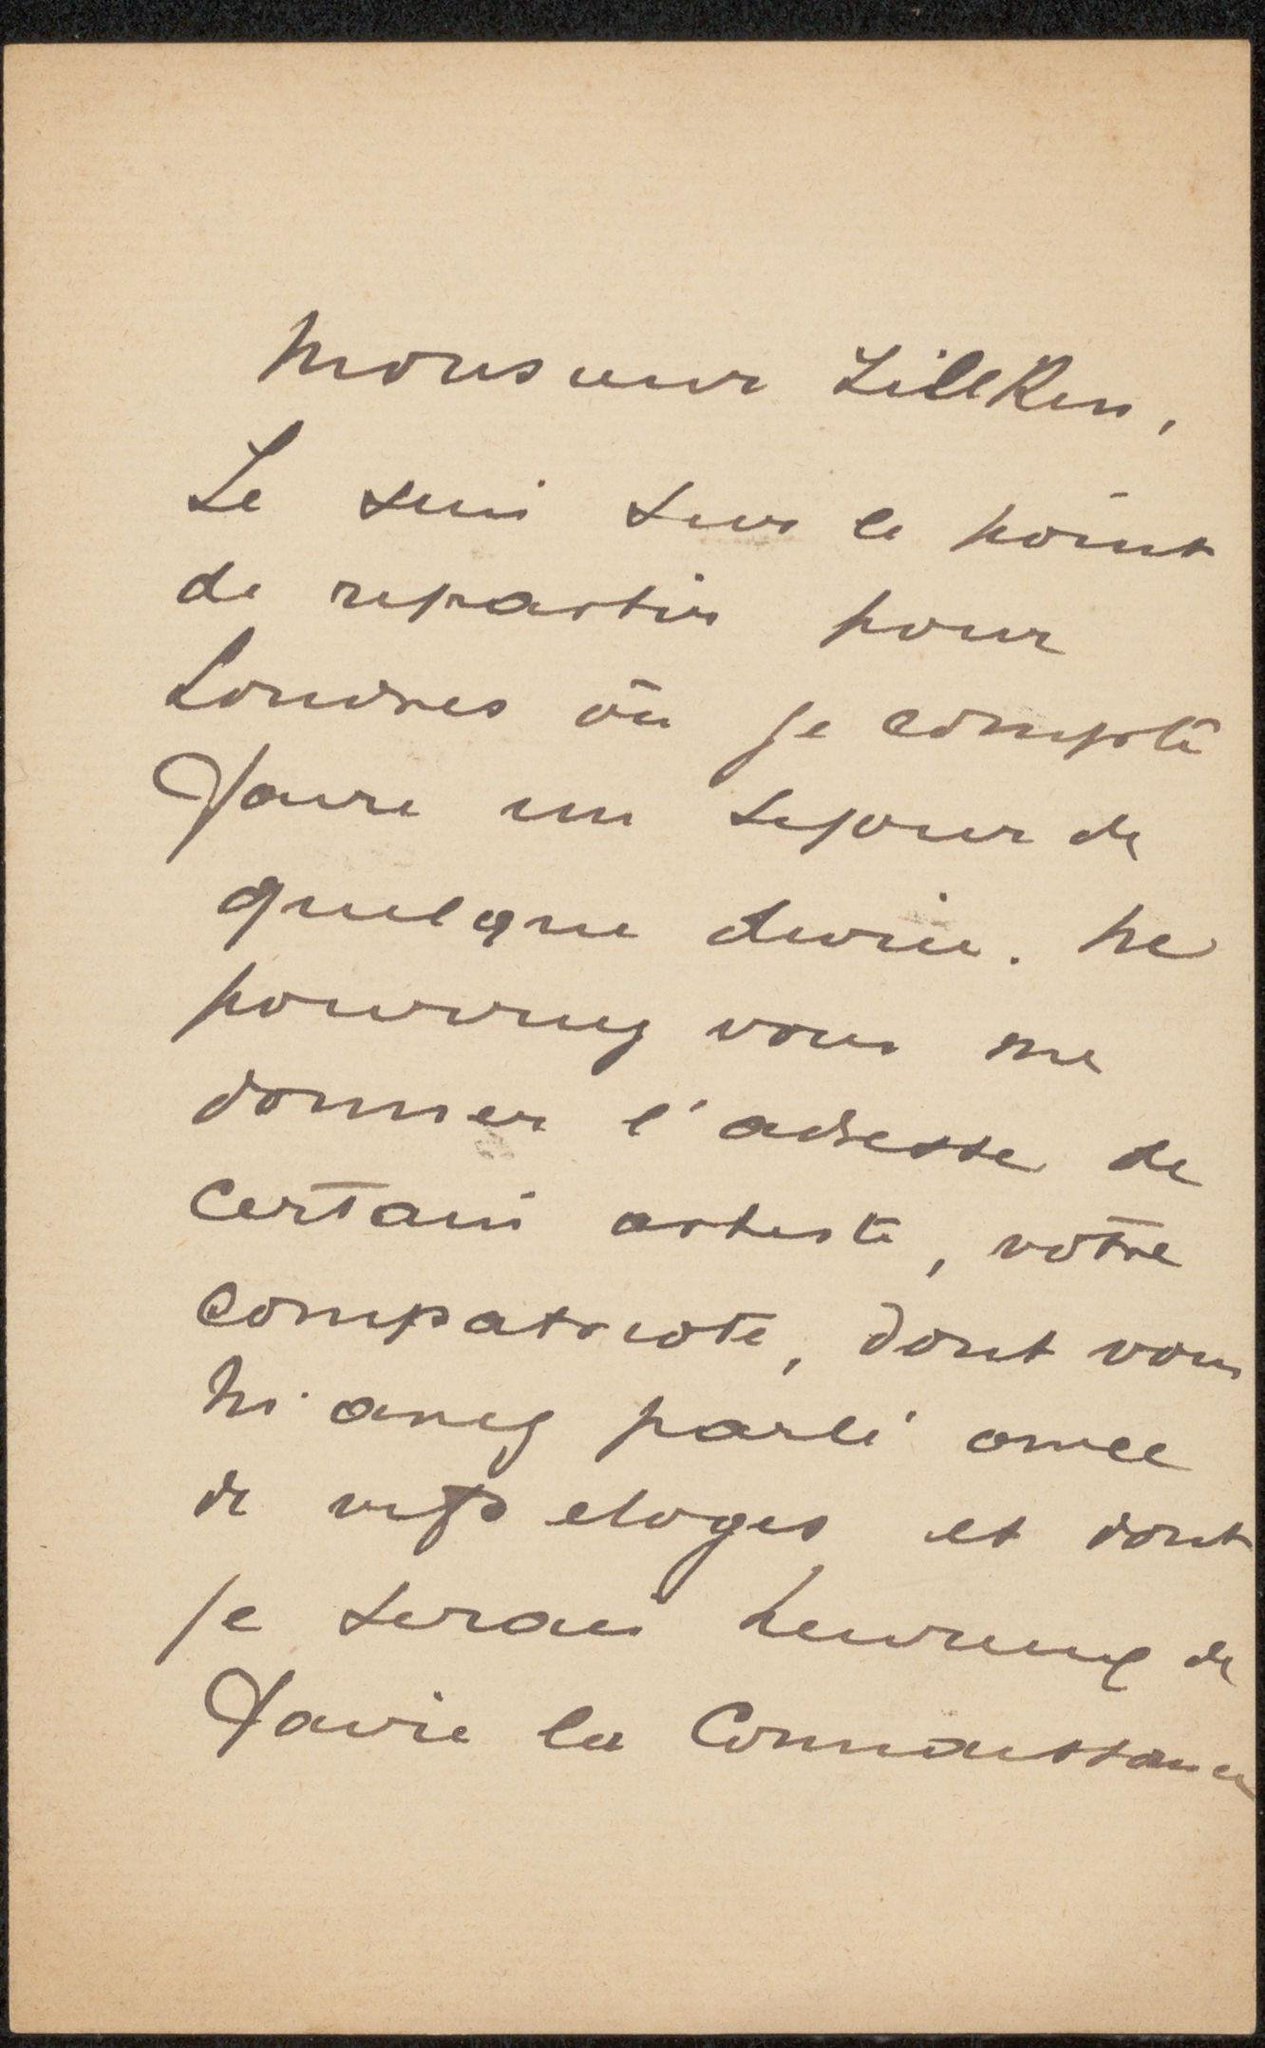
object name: letter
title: Brief aan Philip Zilcken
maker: albert baertsoen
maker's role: draughtsman, print maker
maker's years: 1866-1922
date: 1876-1922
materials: ink, paper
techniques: pen, writing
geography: oostende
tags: the hague, painter, draughtsman, philip zilcken, london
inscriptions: collector's mark: ‘RPK’